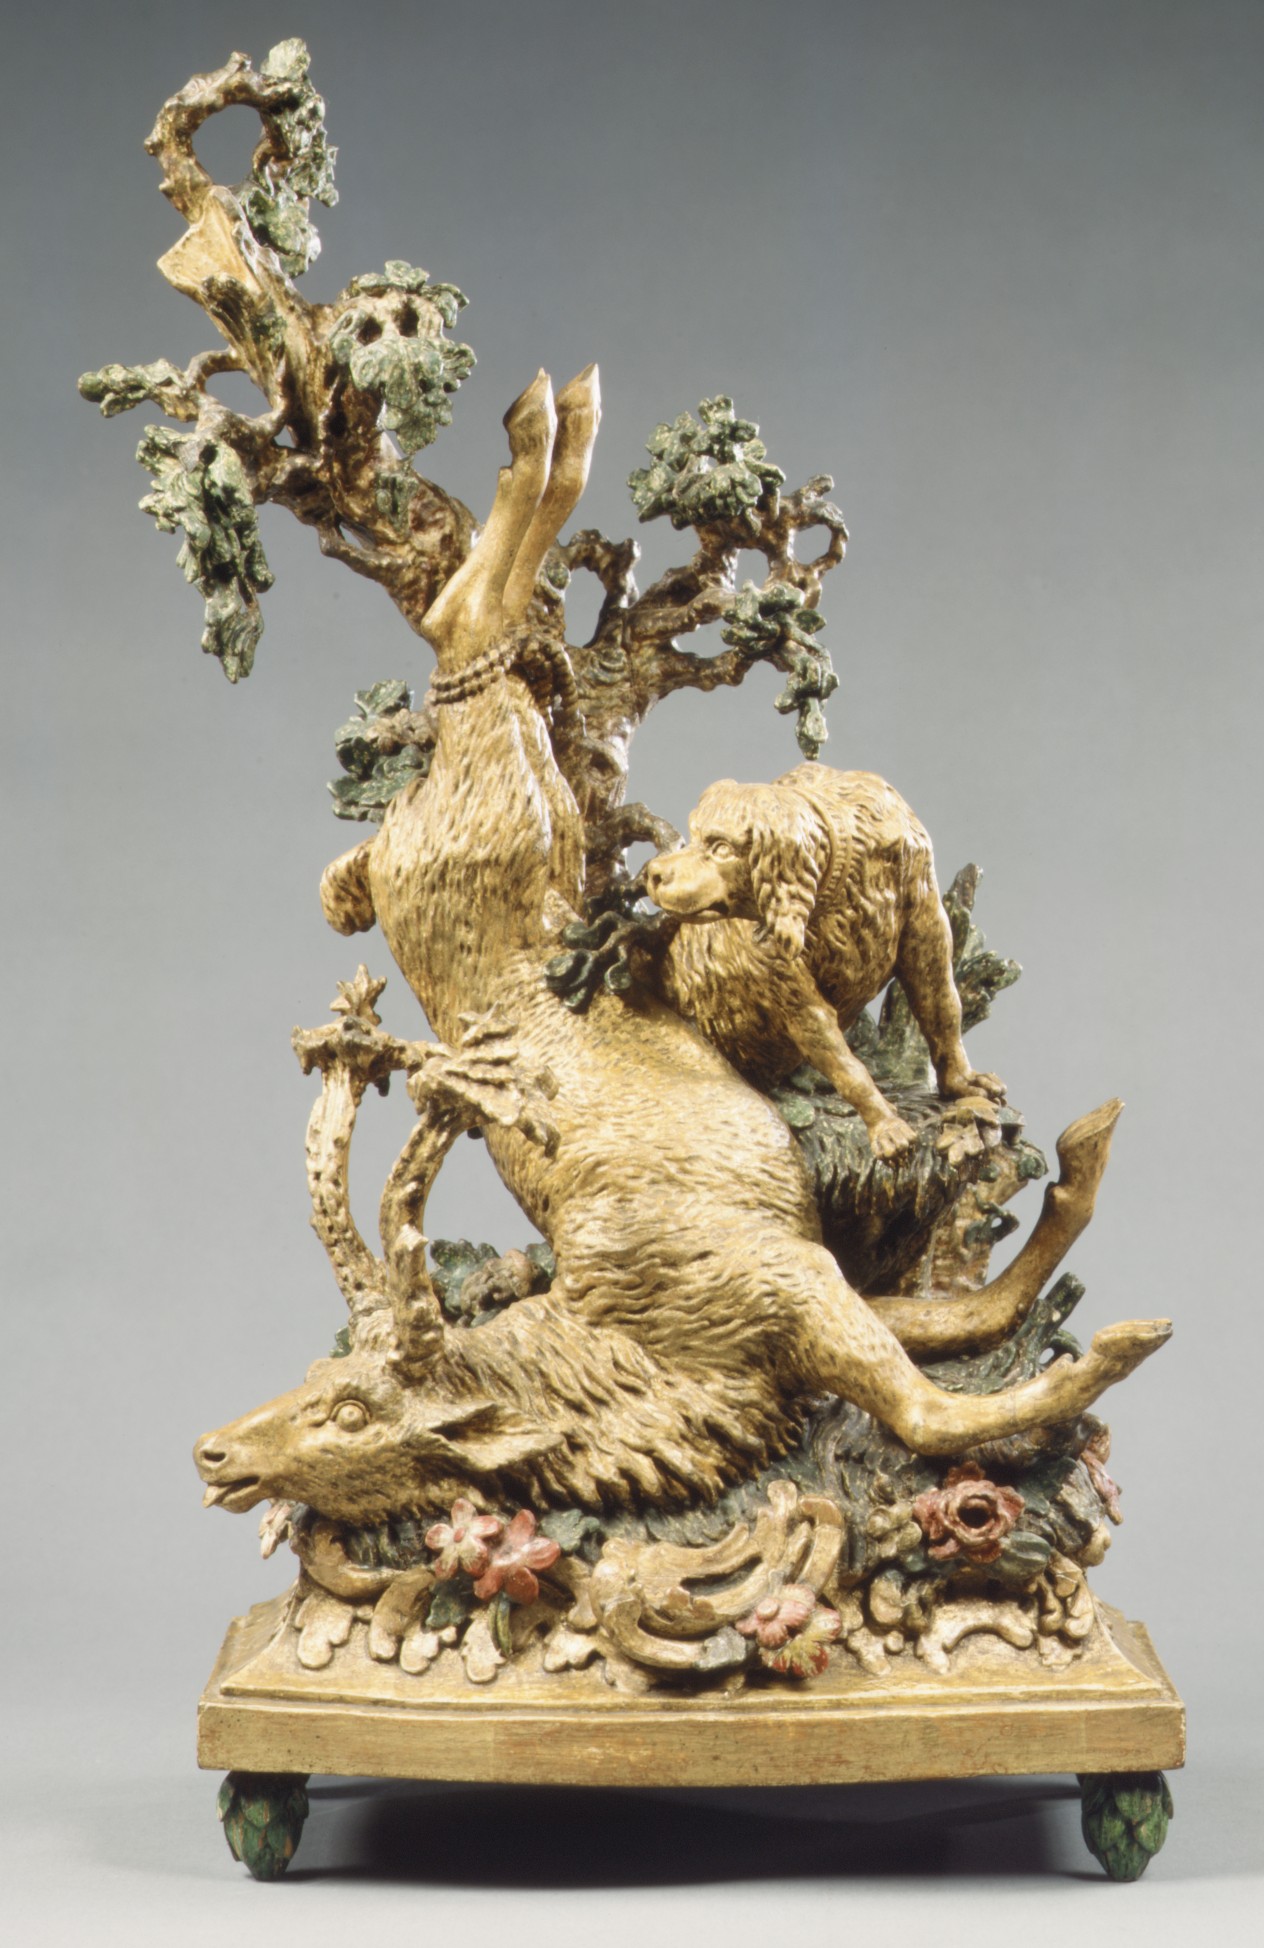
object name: statuette group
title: Dead stag and a hound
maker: ferdinand tietz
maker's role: artist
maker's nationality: austrian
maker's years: 1708-1777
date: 1734-1766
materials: wood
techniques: gilding, polychrome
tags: deer,dogs,flowers,trees